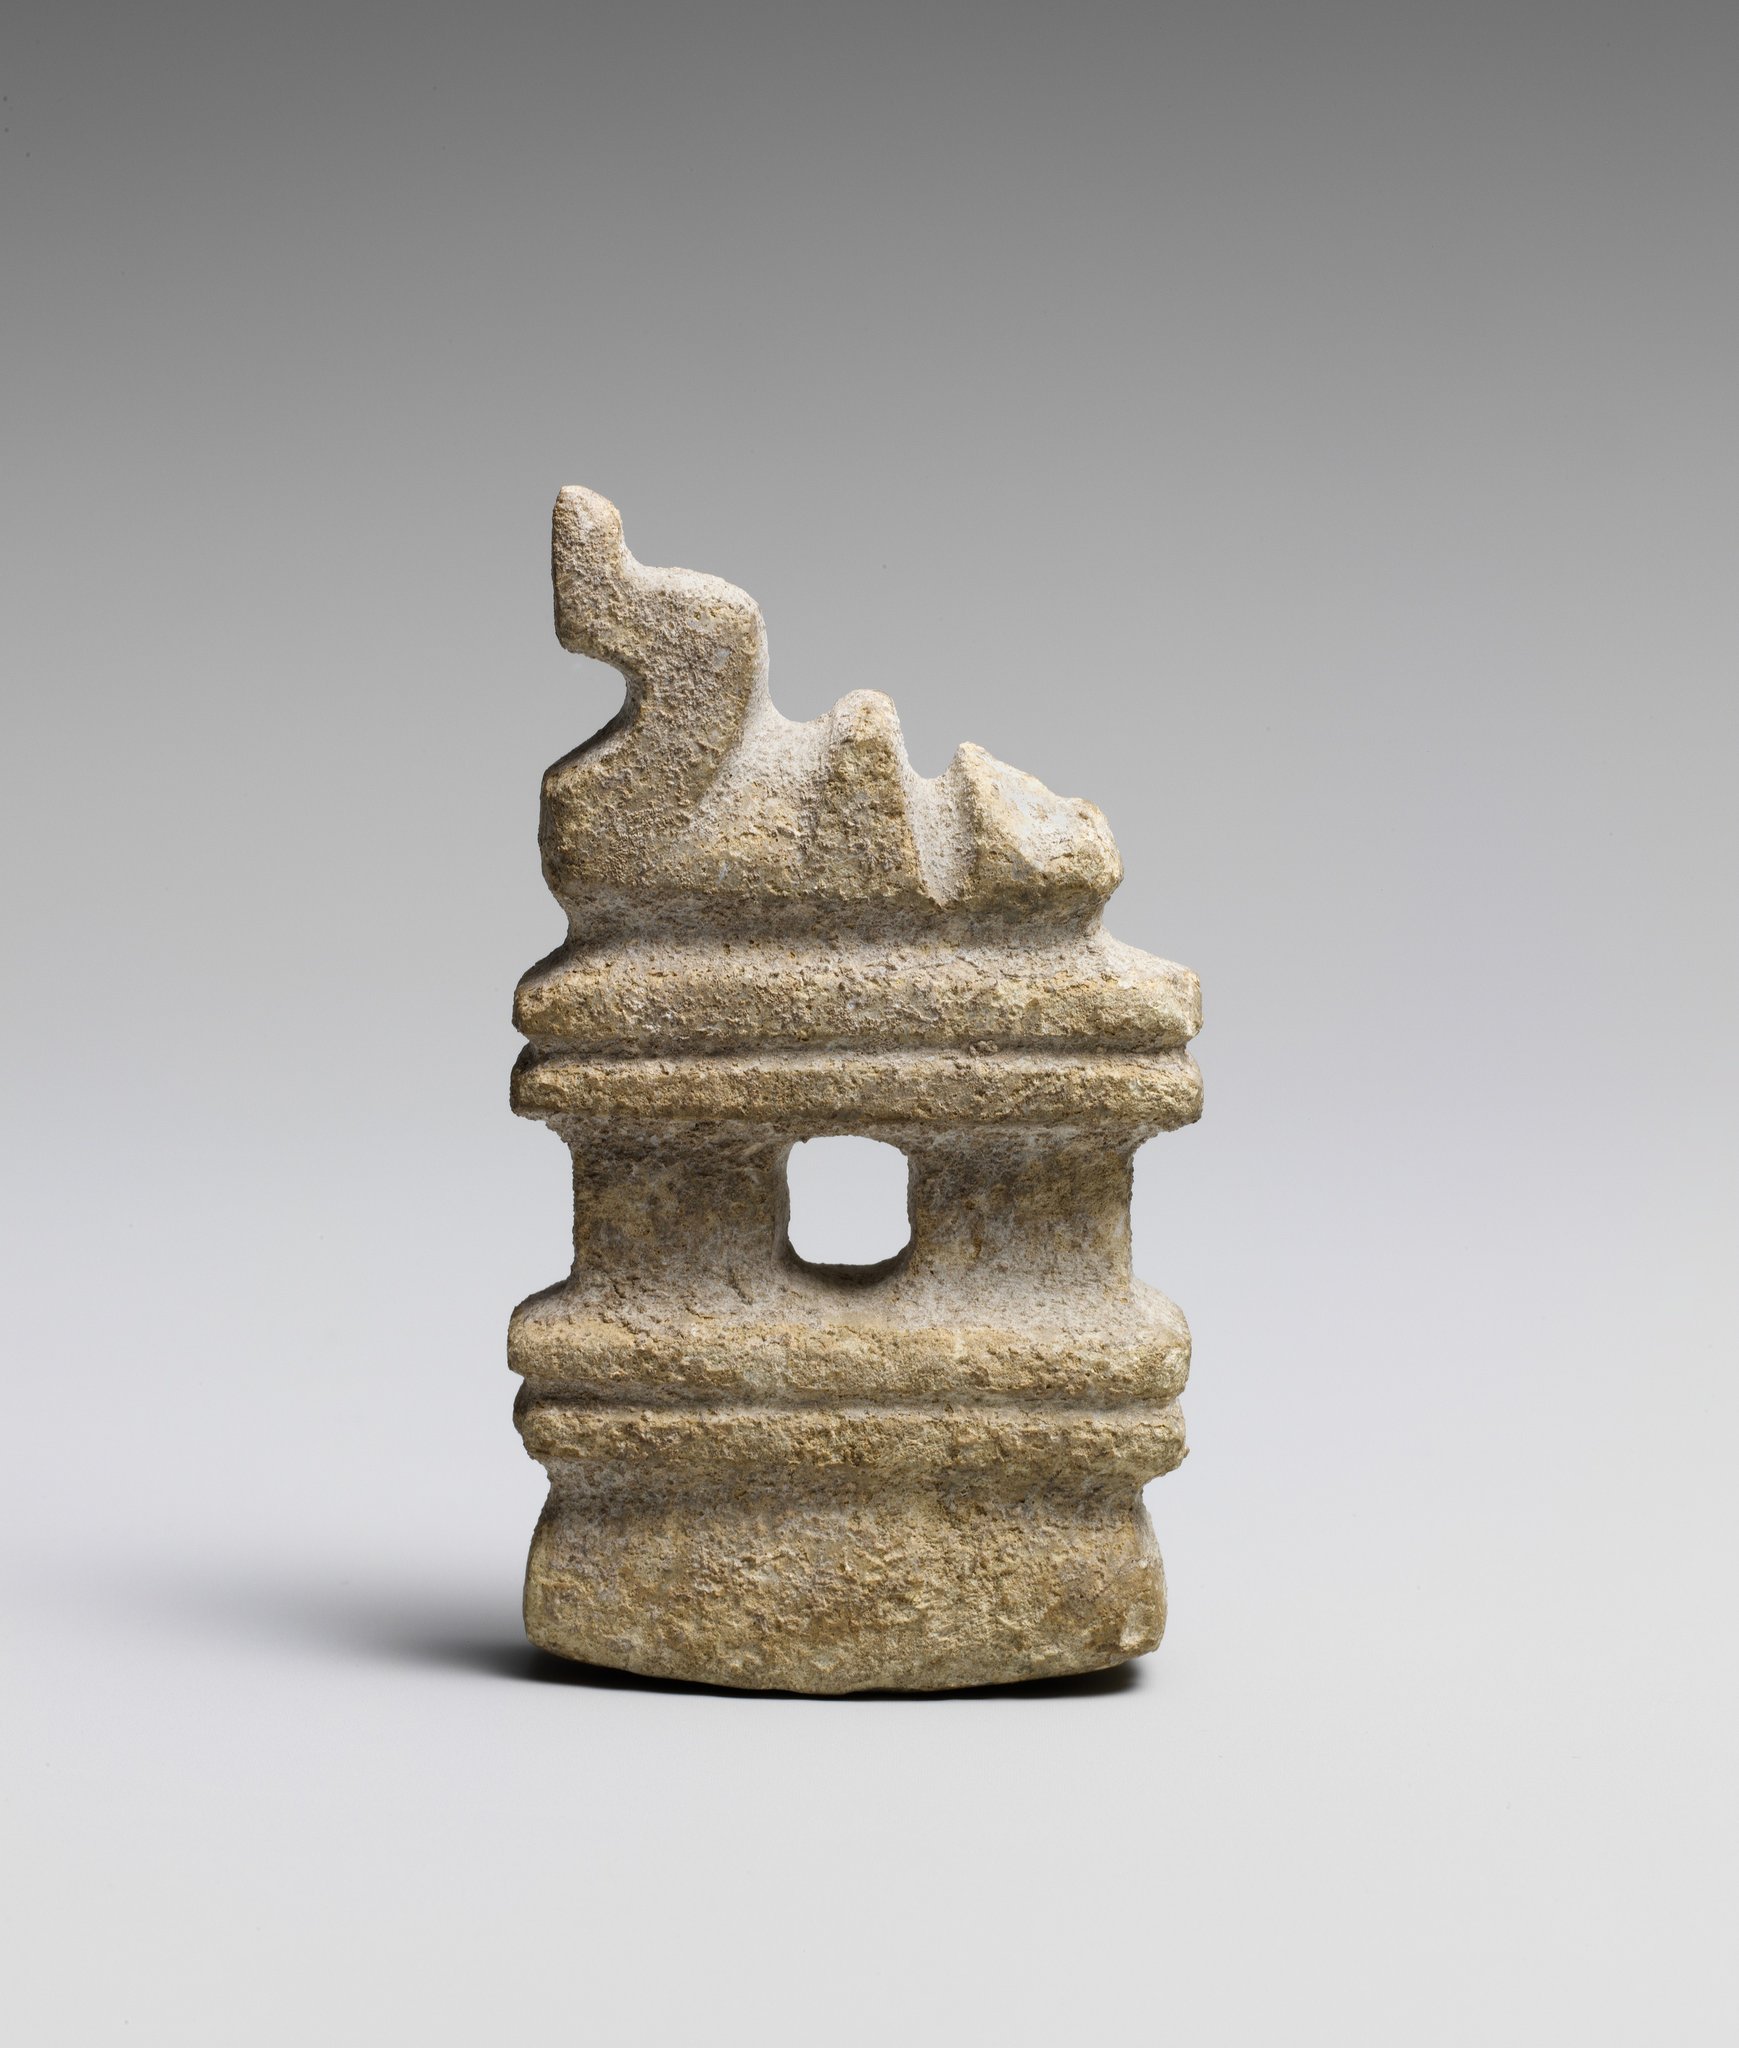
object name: architectural model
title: Architectural Model with Figure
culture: mezcala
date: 1-800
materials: stone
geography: mexico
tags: temples